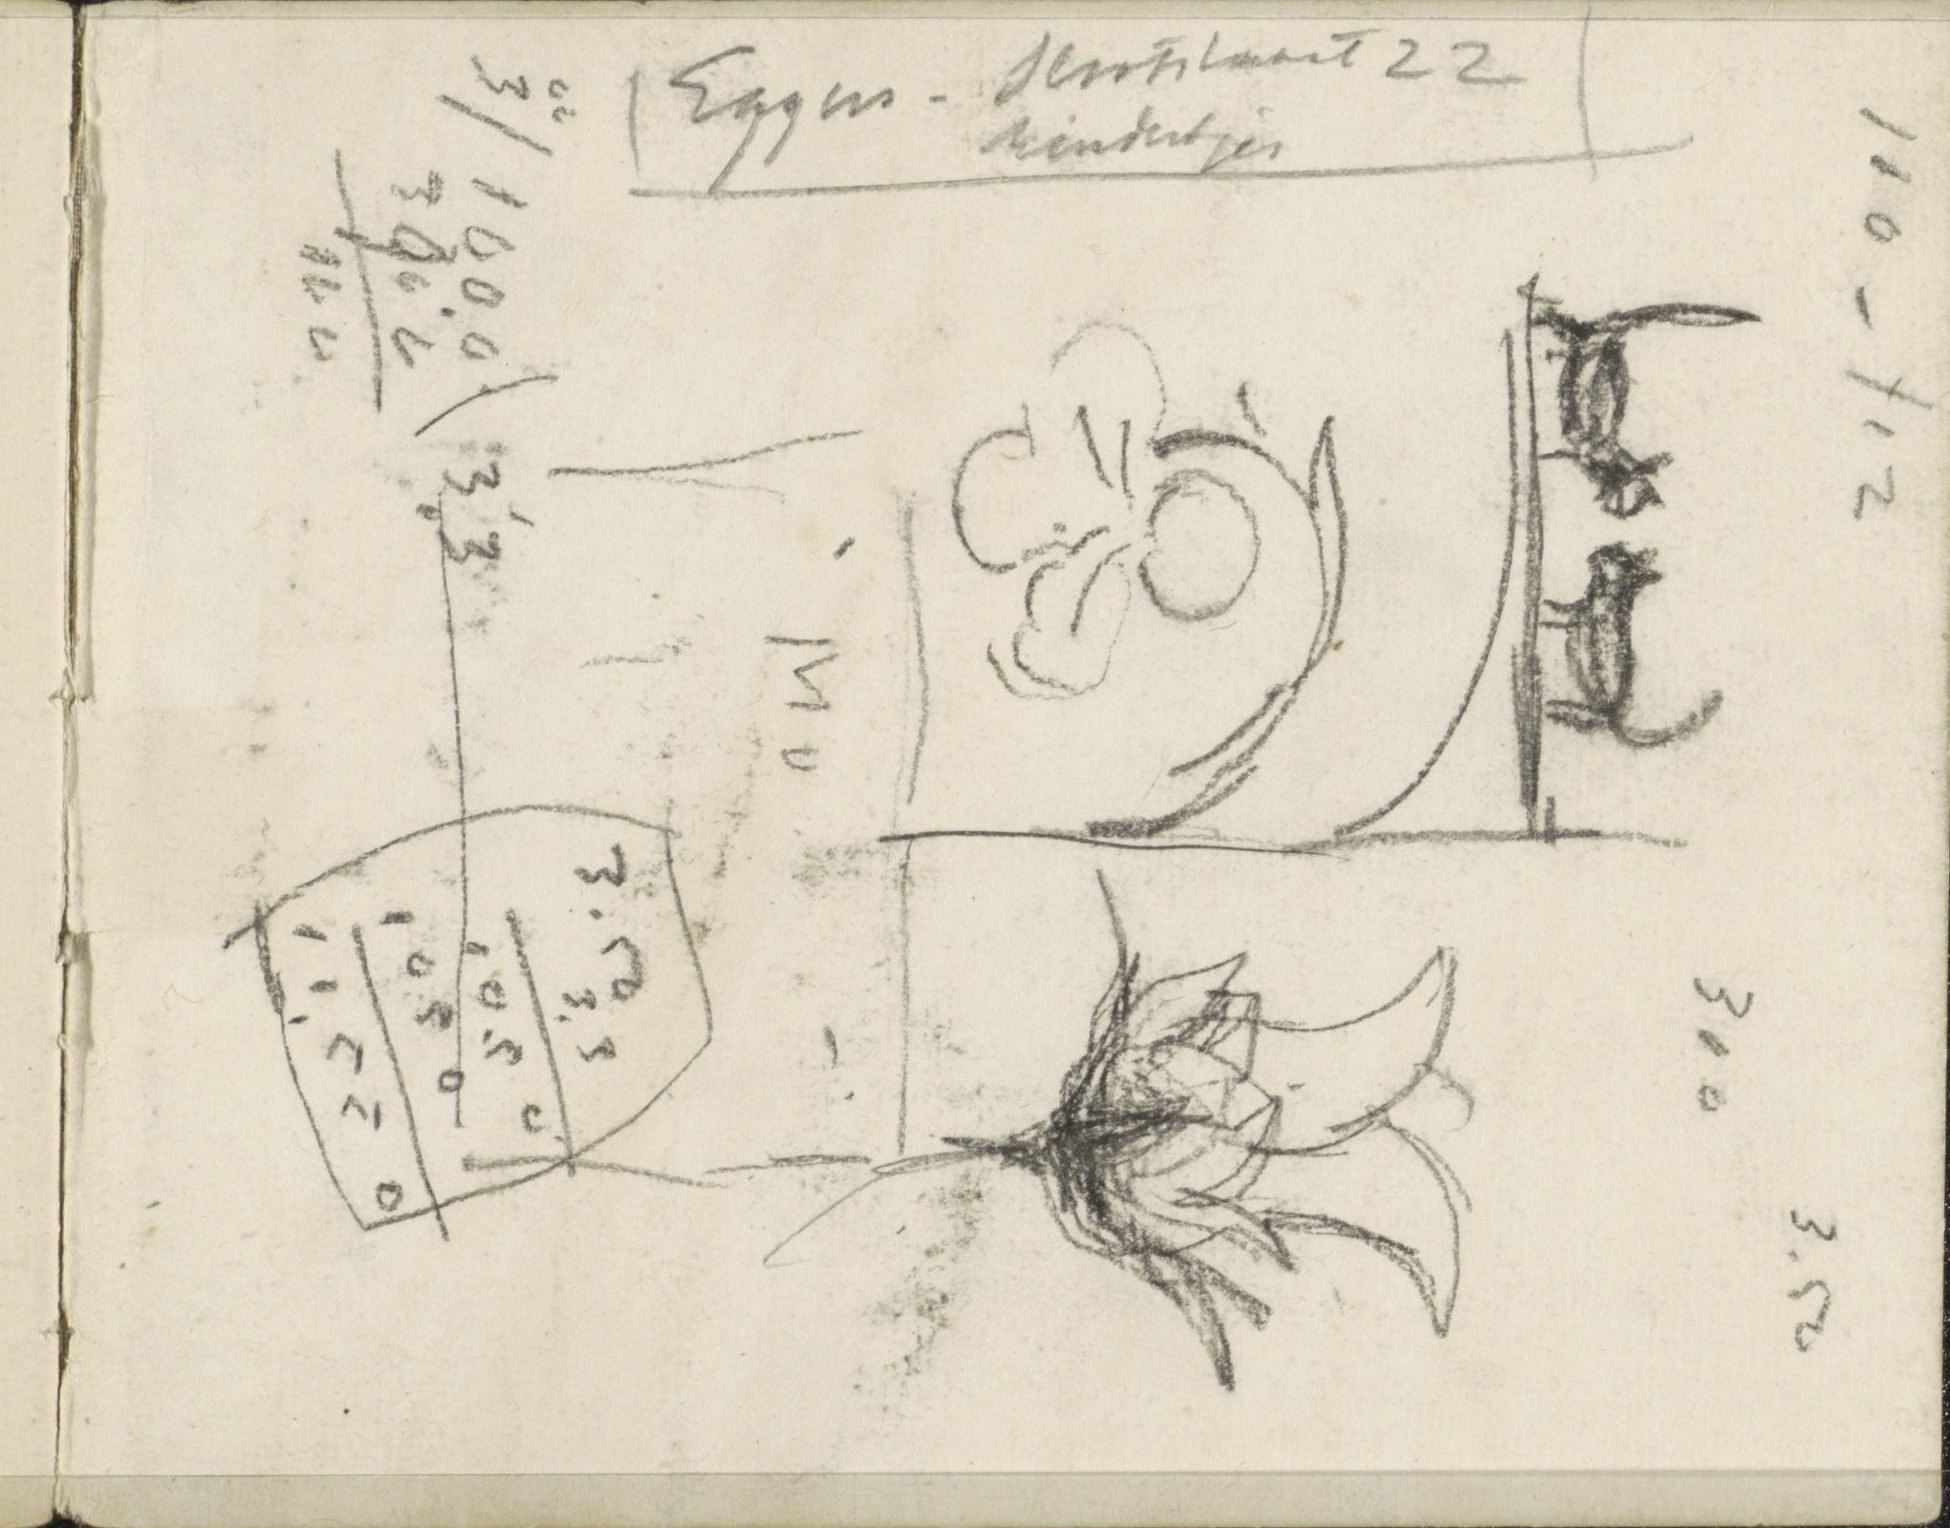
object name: endleaf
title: Studieblad met een bloem, een ornament en twee katten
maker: george hendrik breitner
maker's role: draughtsman, painter, print maker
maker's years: 1857-1923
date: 1885-1898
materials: chalk, paper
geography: amsterdam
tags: flowers, cat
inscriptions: annotation: ‘[...] Eggers, [...]straat 22/ kindertjes’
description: Pagina 66, achterste schutblad, uit een schetsboek met 32 bladen.